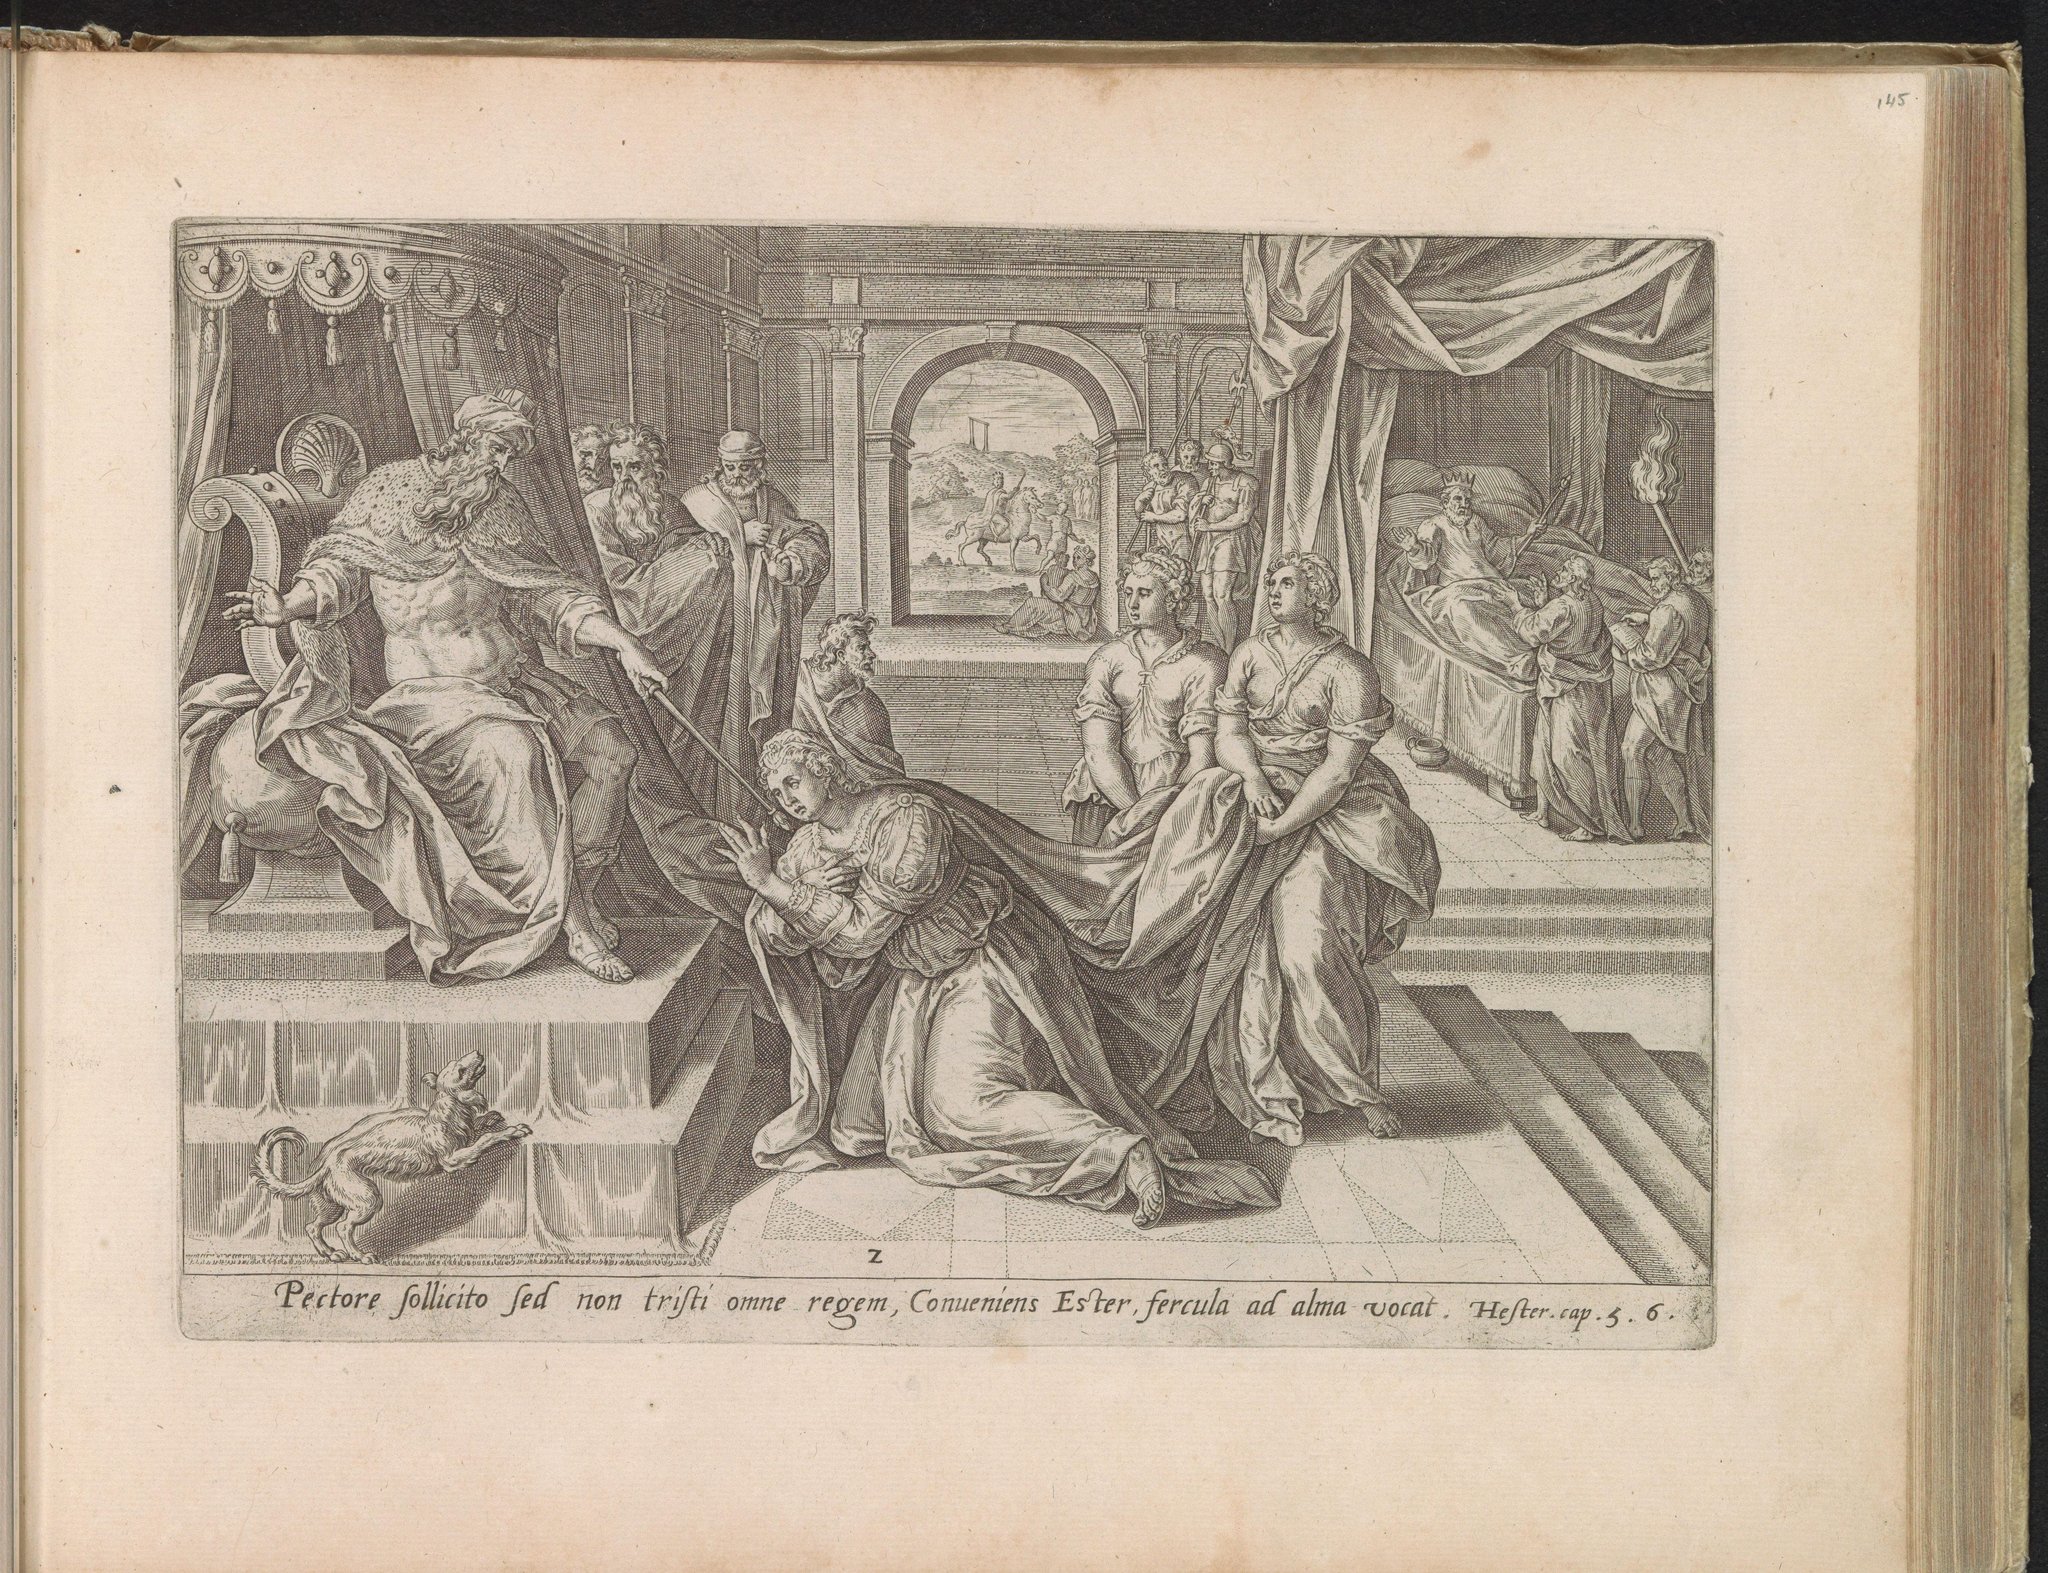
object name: print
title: Geschiedenis van Ester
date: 1585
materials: paper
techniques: engraving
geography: antwerp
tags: mordecai's triumph: mordecai, mounted on the king's horse, is led through the city by haman (esther and ahasuerus may be looking on from the palace), ahasuerus holds out his sceptre to esther (esther usually kneeling), ahasuerus being sleepless, has the court records read to him, king ahasuerus asks haman how to honour a man he wishes to reward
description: Ester knielt voor koning Ahasveros. De koning wijst zijn scepter naar haar als teken van genegenheid. Ester verzoekt de koning om samen met Haman naar het door haar verzorgde feestmaal te komen. Rechts op de achtergrond het vervolg van het verhaal. De koning laat zich 's avonds voorlezen uit de kronieken van het rijk. Daarin staat dat Mordechai een aanslag op het leven van de koning heeft verijdeld. De koning vraagt aan Haman, die bij het bed staat, hoe iemand die het leven van de koning heeft gered geëerd moet worden. Op de achtergrond is te zien hoe Mordechai in het kleed van de koning en op het paard van de koning wordt rondgereden, terwijl Haman hem rondleidt. Onder de voorstelling een verwijzing in het Latijn naar de Bijbeltekst in Est. 5-6. Deze prent maakt deel uit van een album.